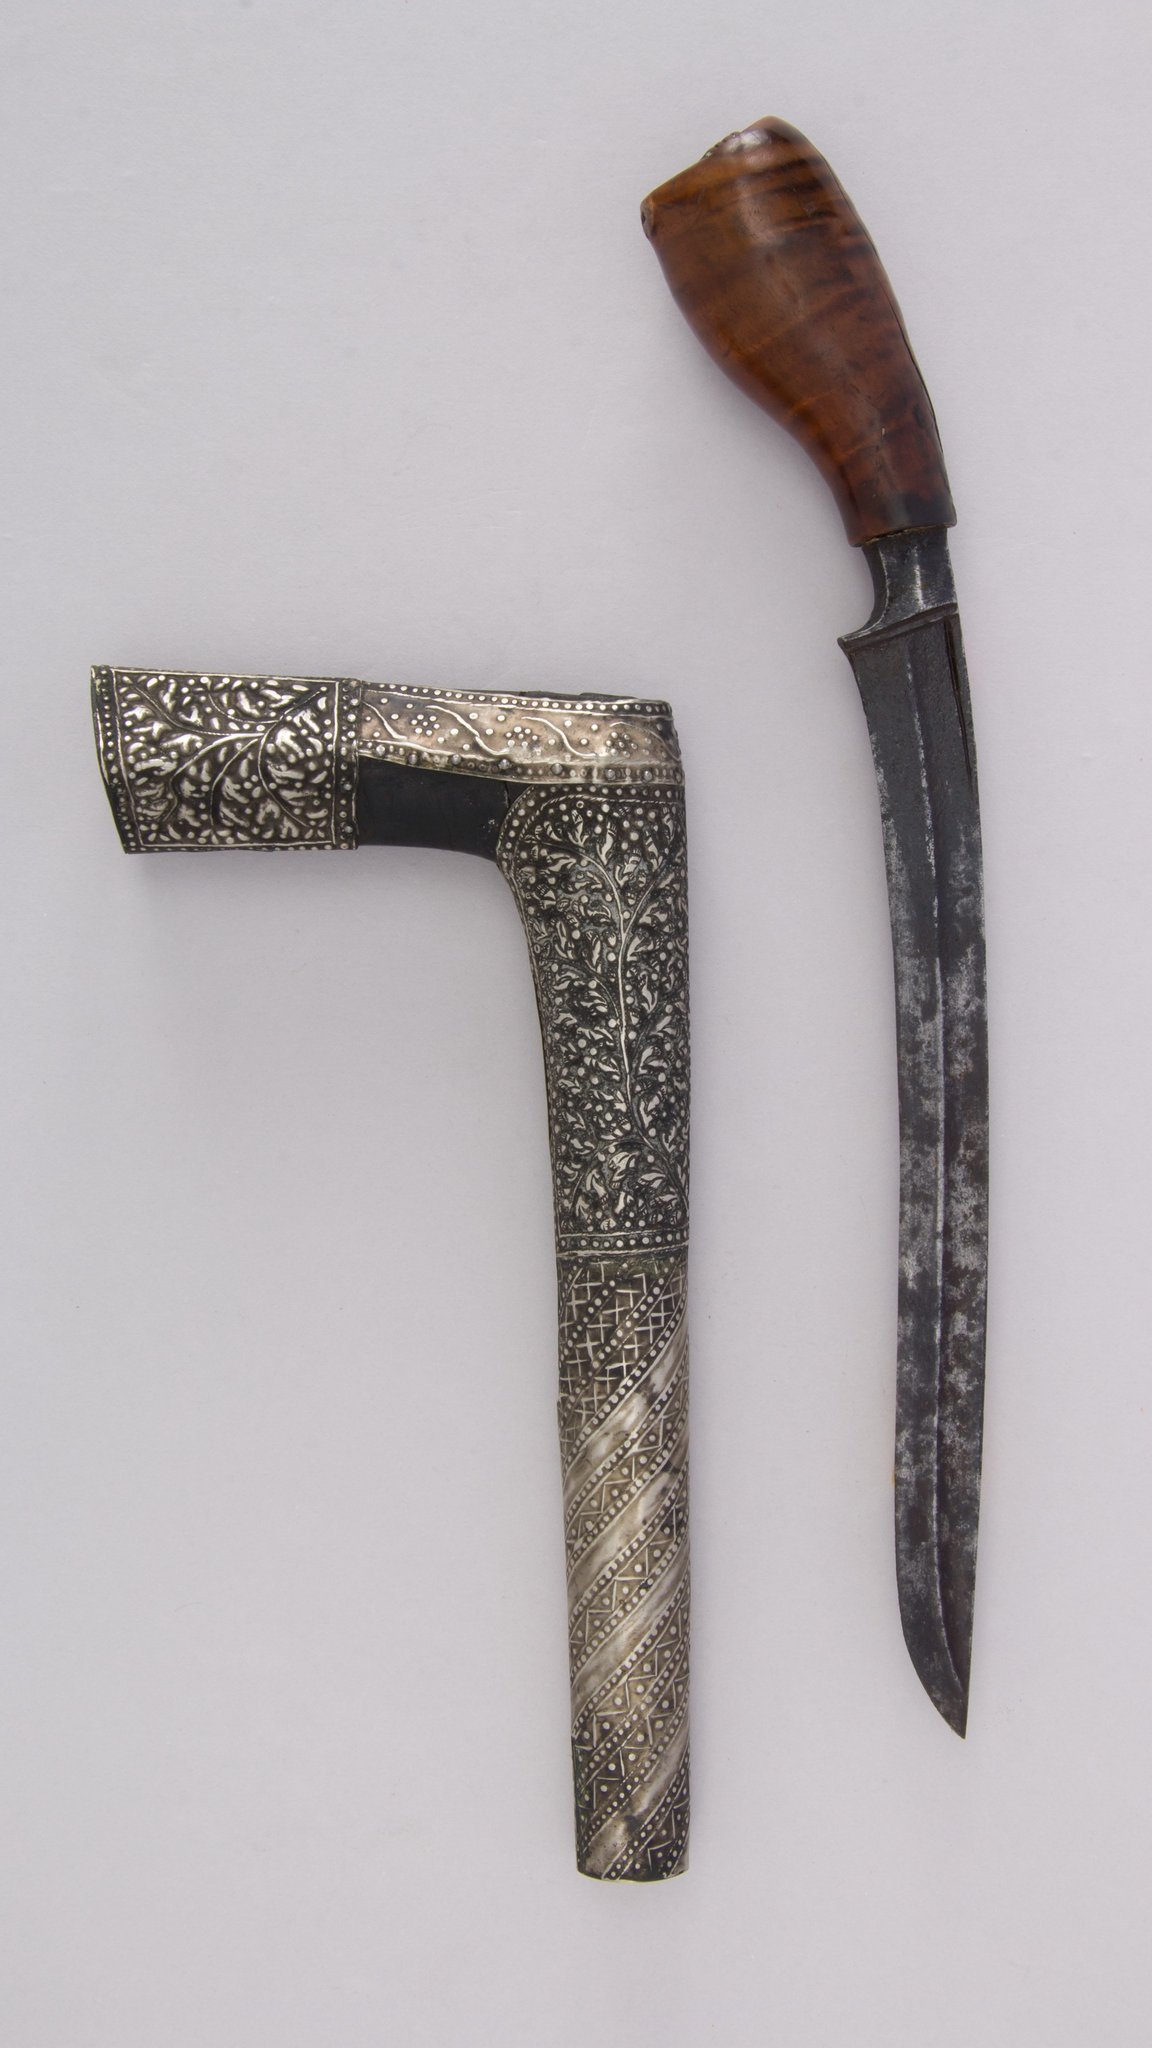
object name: knife bade bade with sheath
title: Knife (Bade-bade) with Sheath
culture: minangkabau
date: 1701-1900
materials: silver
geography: malaysia